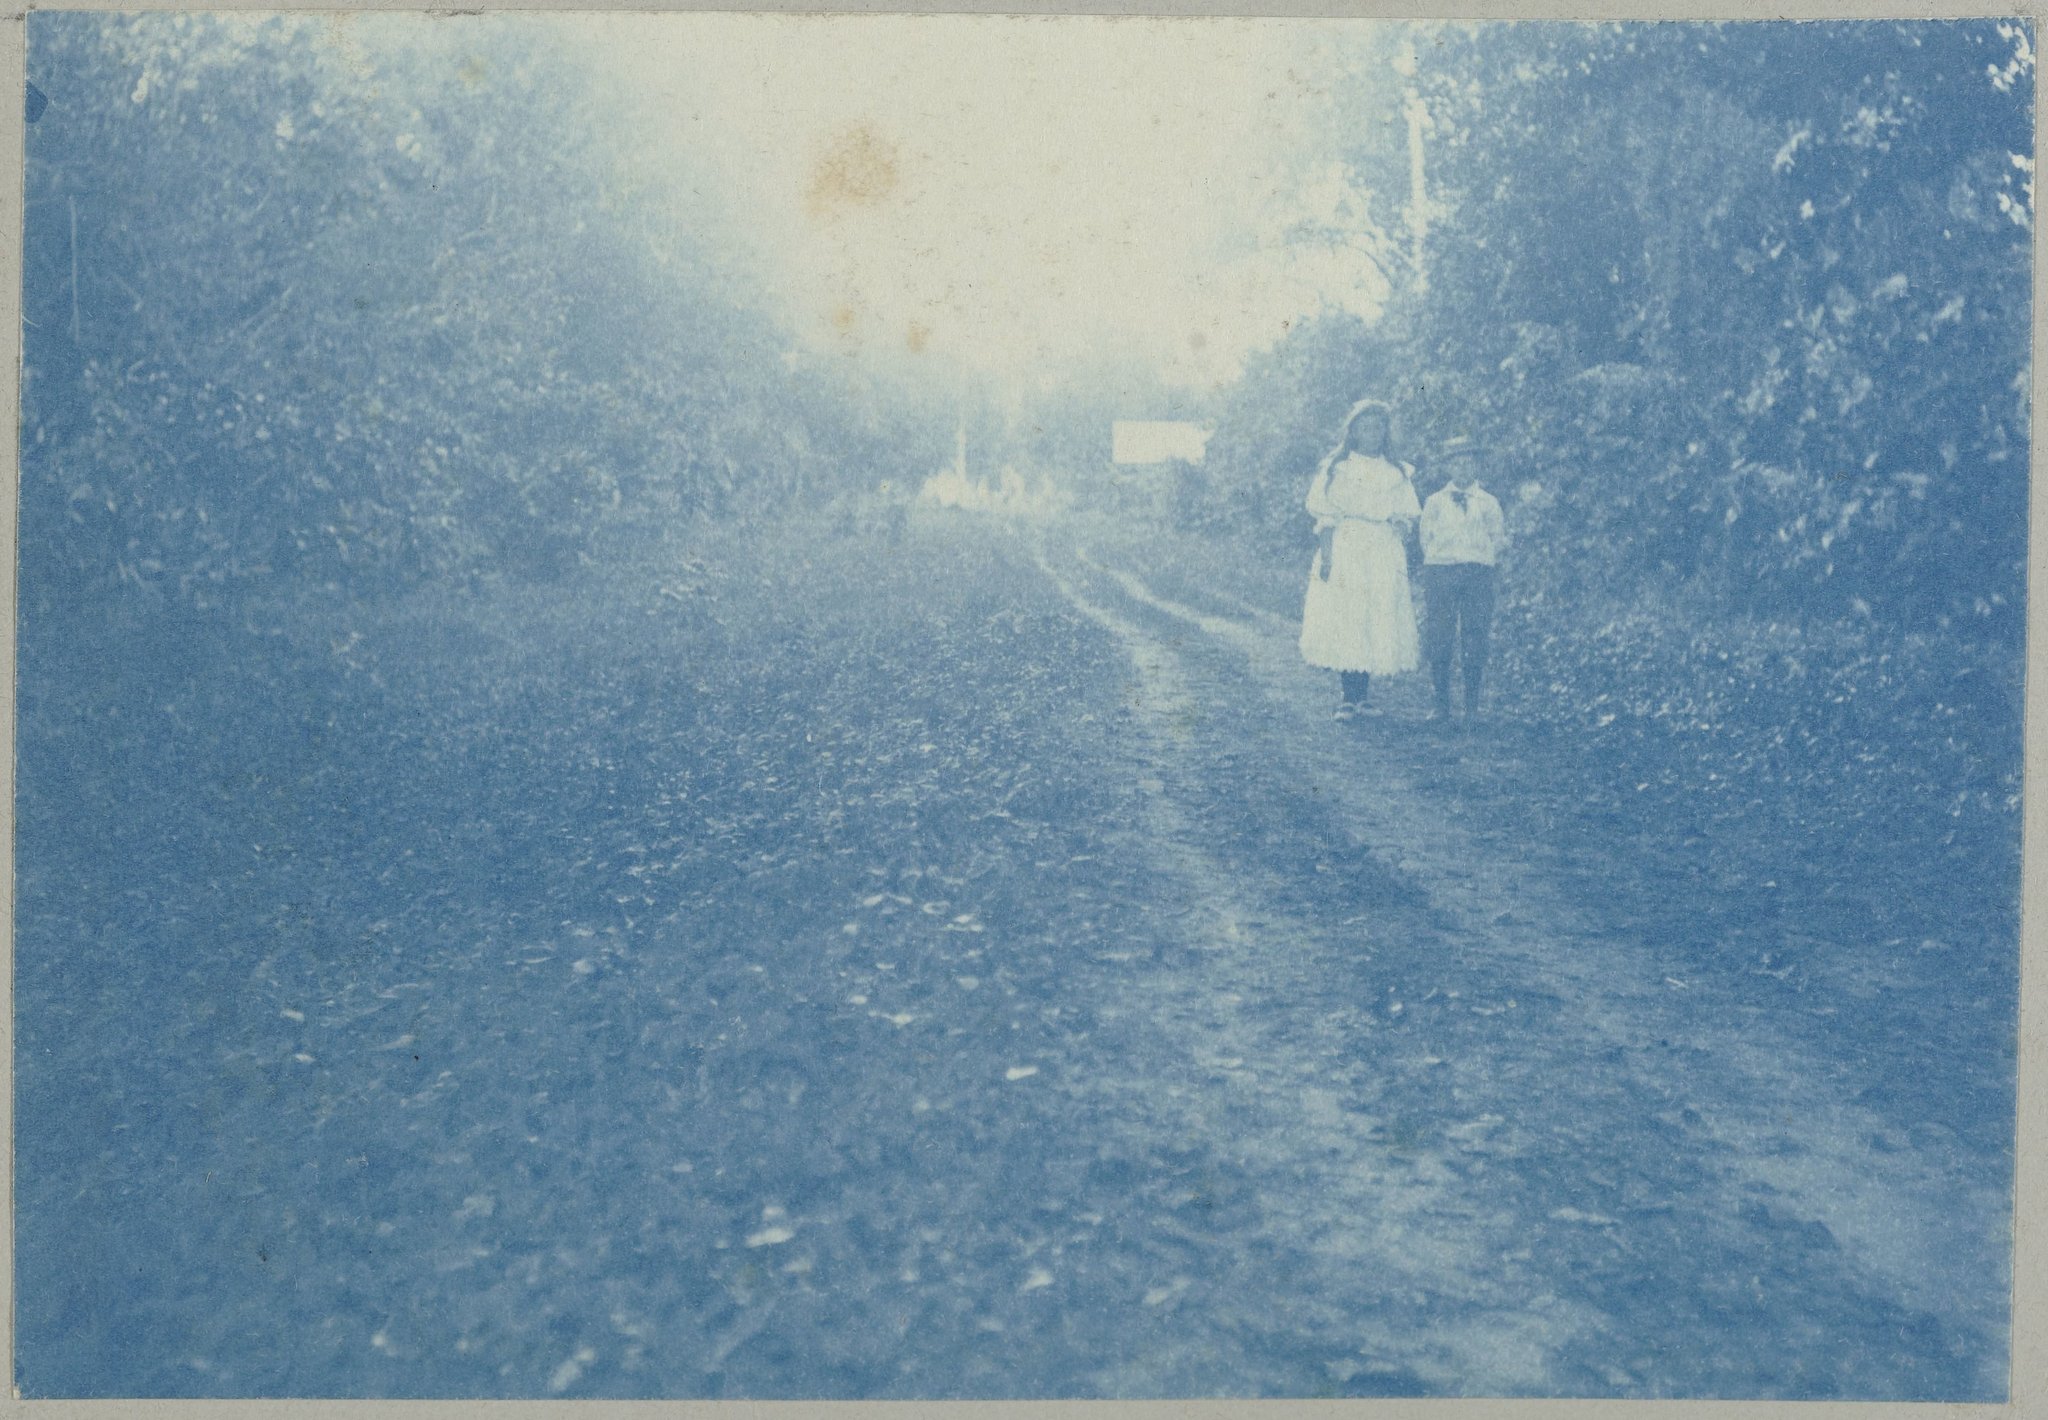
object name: photograph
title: To en Anton op Tourtonne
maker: hendrik doijer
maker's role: engineer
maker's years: 1863-1925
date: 1903-1910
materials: photographic support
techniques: cyanotype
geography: suriname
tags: suriname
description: Nederlandse meisje en jongen genaamd To en Anton poseren staand op een weg op het terrein van de Plantage Tourtonne. Onderdeel van het fotoalbum Souvenir de Voyage (deel 2), over het leven van de familie Doijer in en rond de plantage Ma Retraite in Suriname in de jaren 1903-1910.